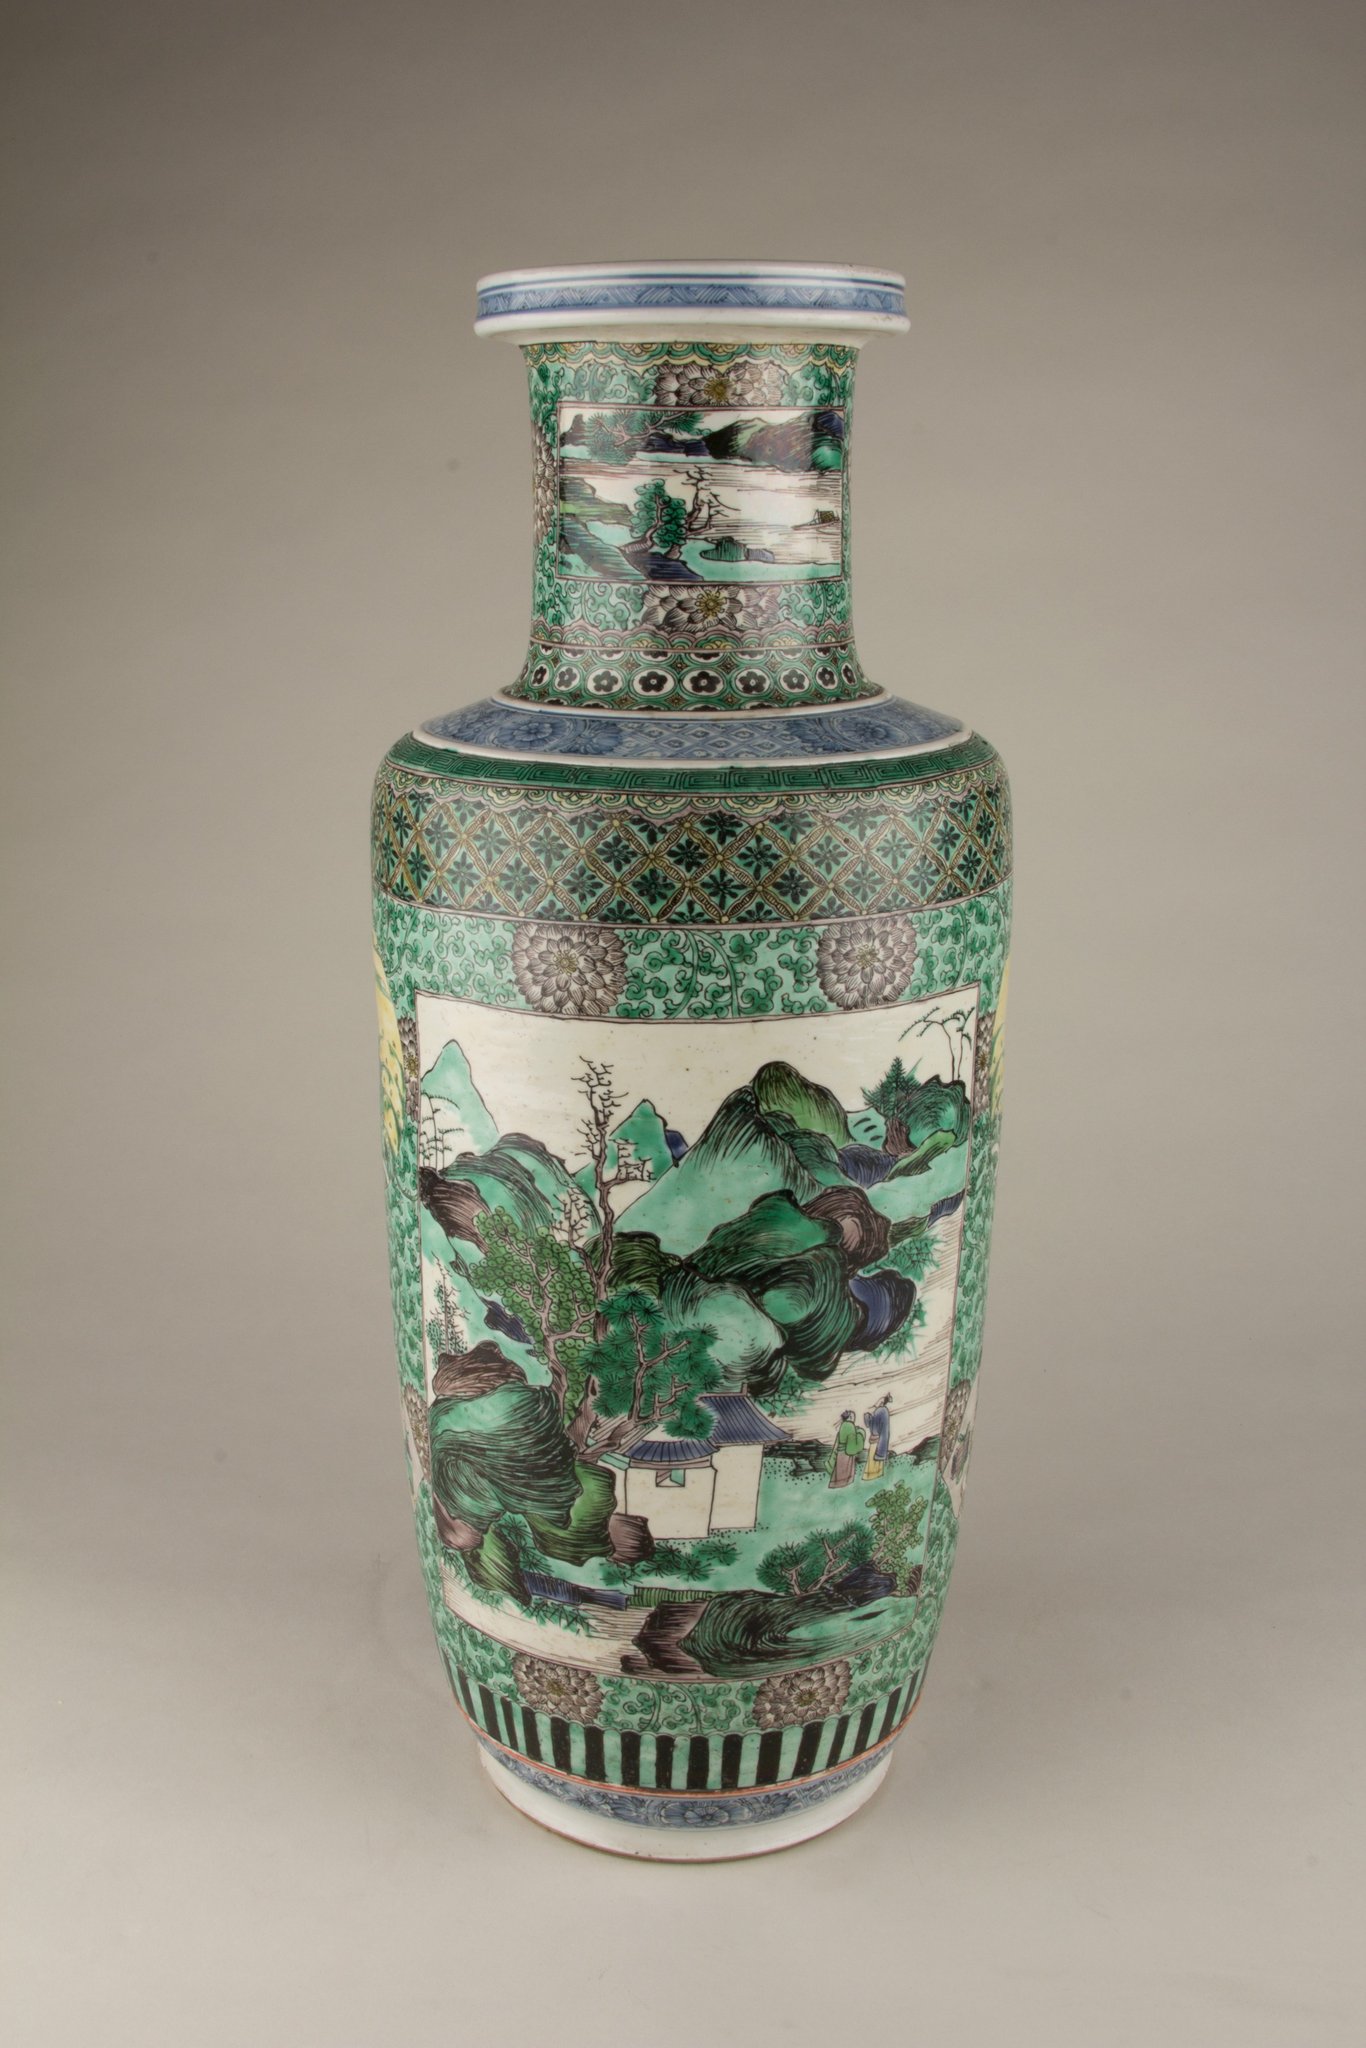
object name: vase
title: Vase with landscape scenes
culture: chinese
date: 1667-1733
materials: cobalt, enamel, porcelain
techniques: overglaze, painting, polychrome, underglaze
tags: fish,flowers,mountains,landscapes